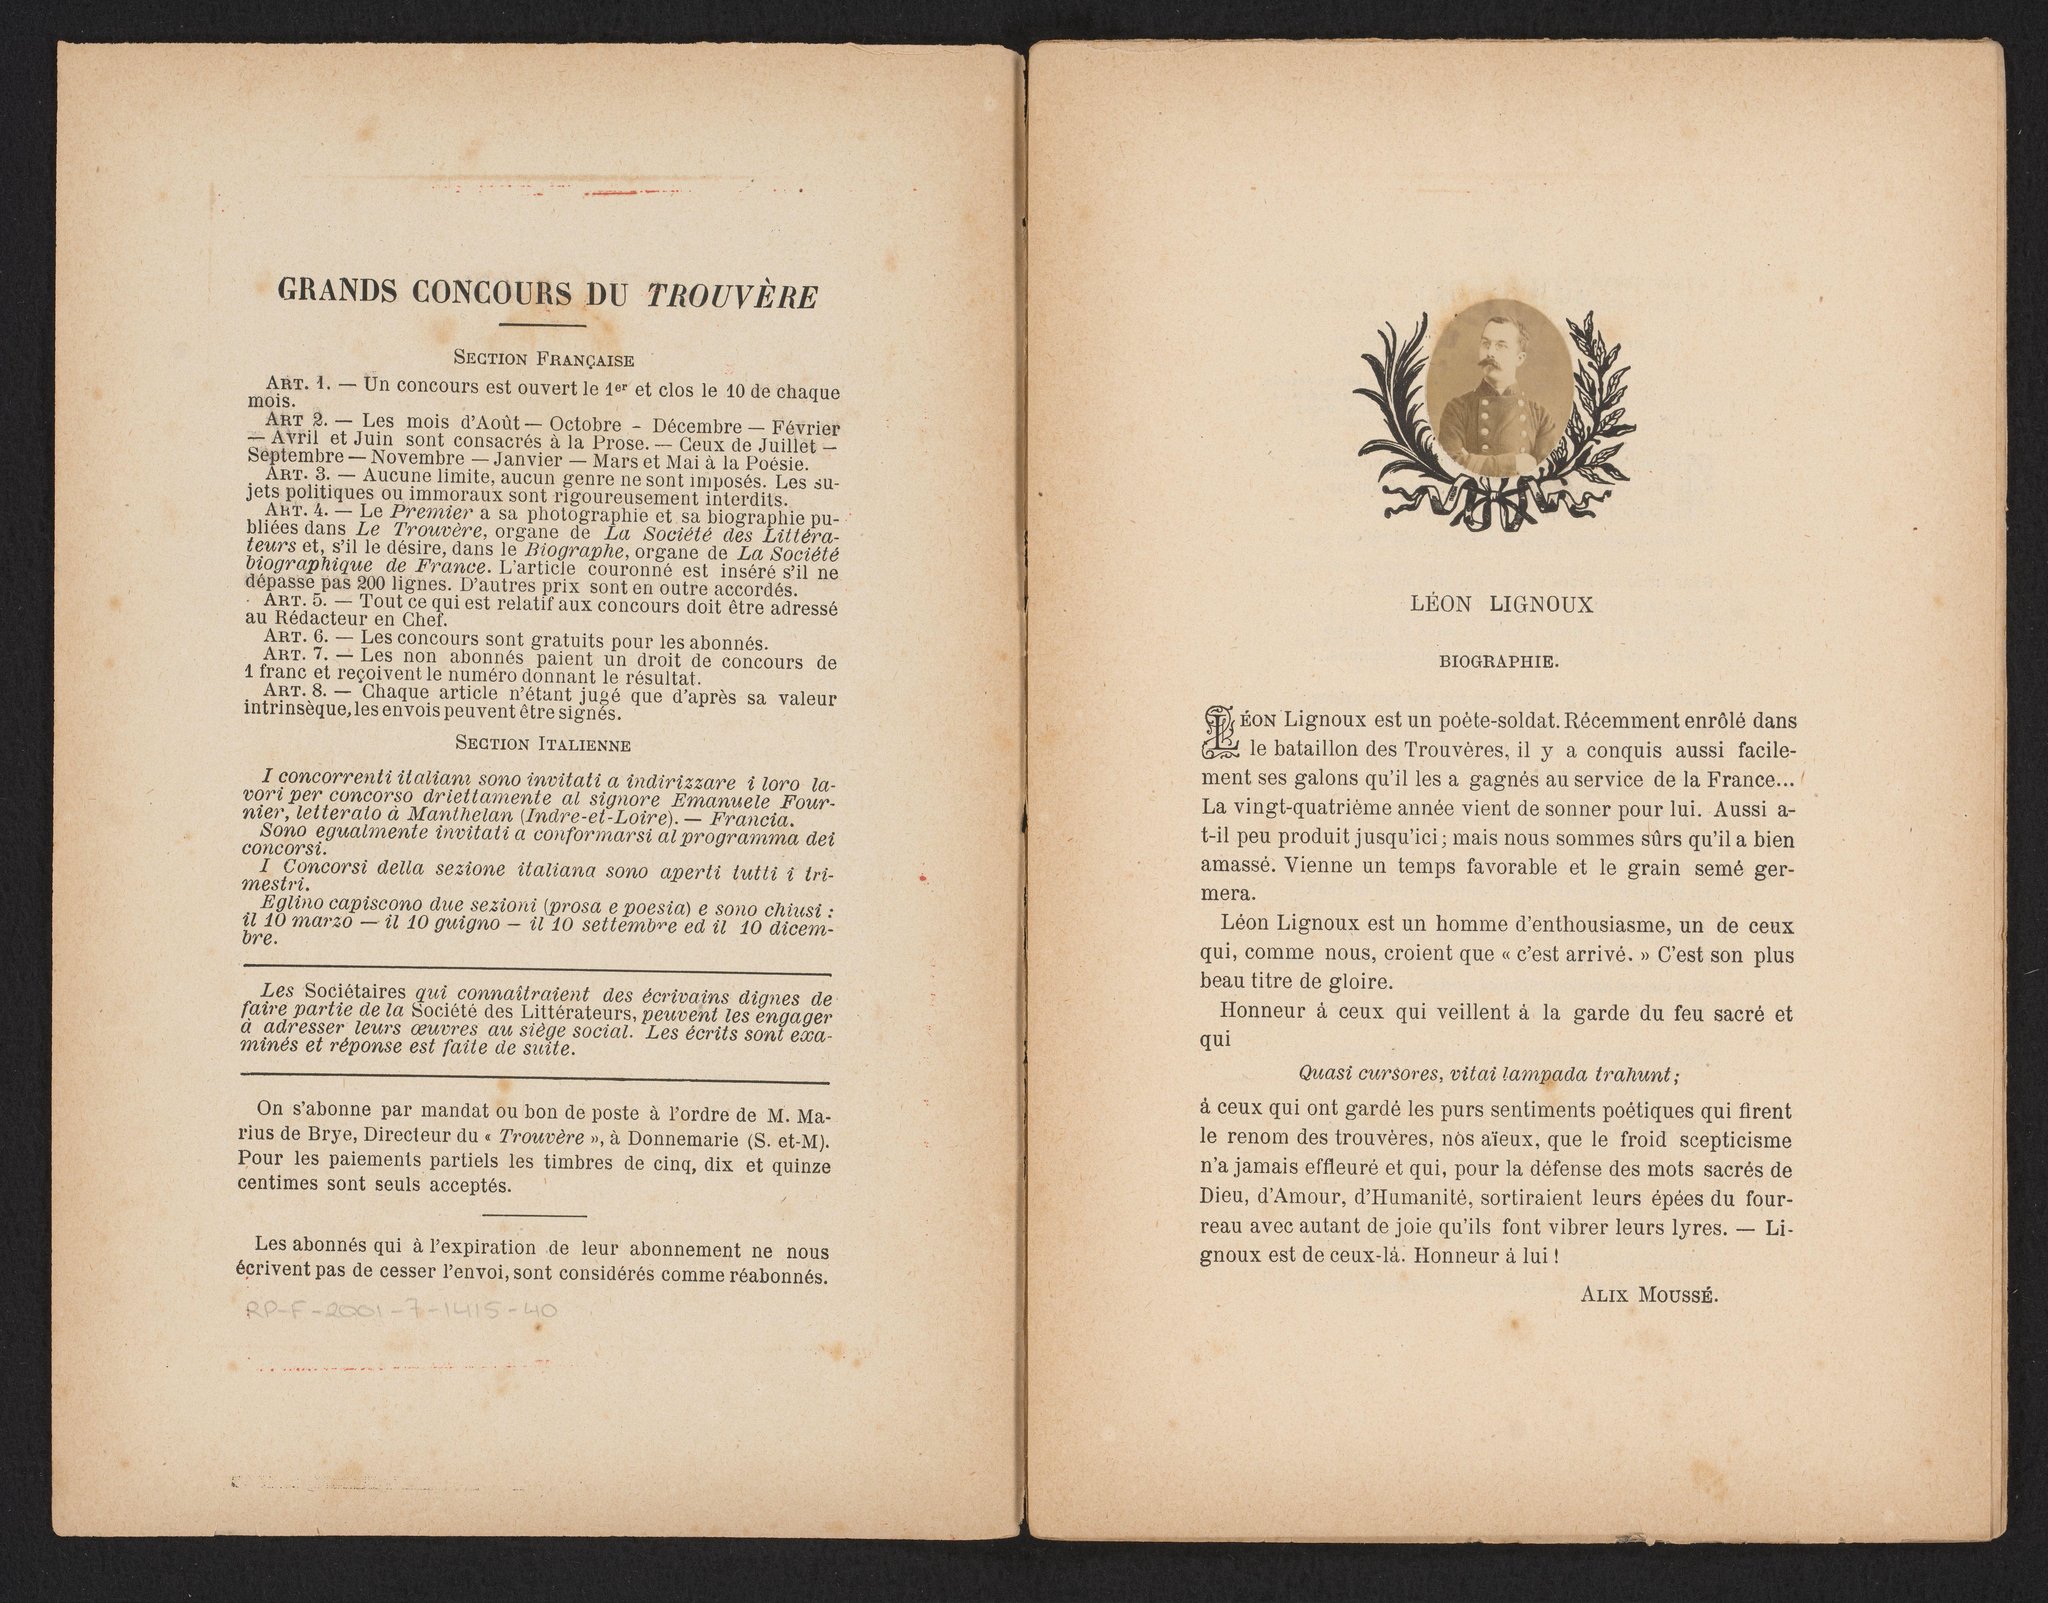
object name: photograph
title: Portret van Léon Lignoux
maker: Anonymous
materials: photographic support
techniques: albumen print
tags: historical persons